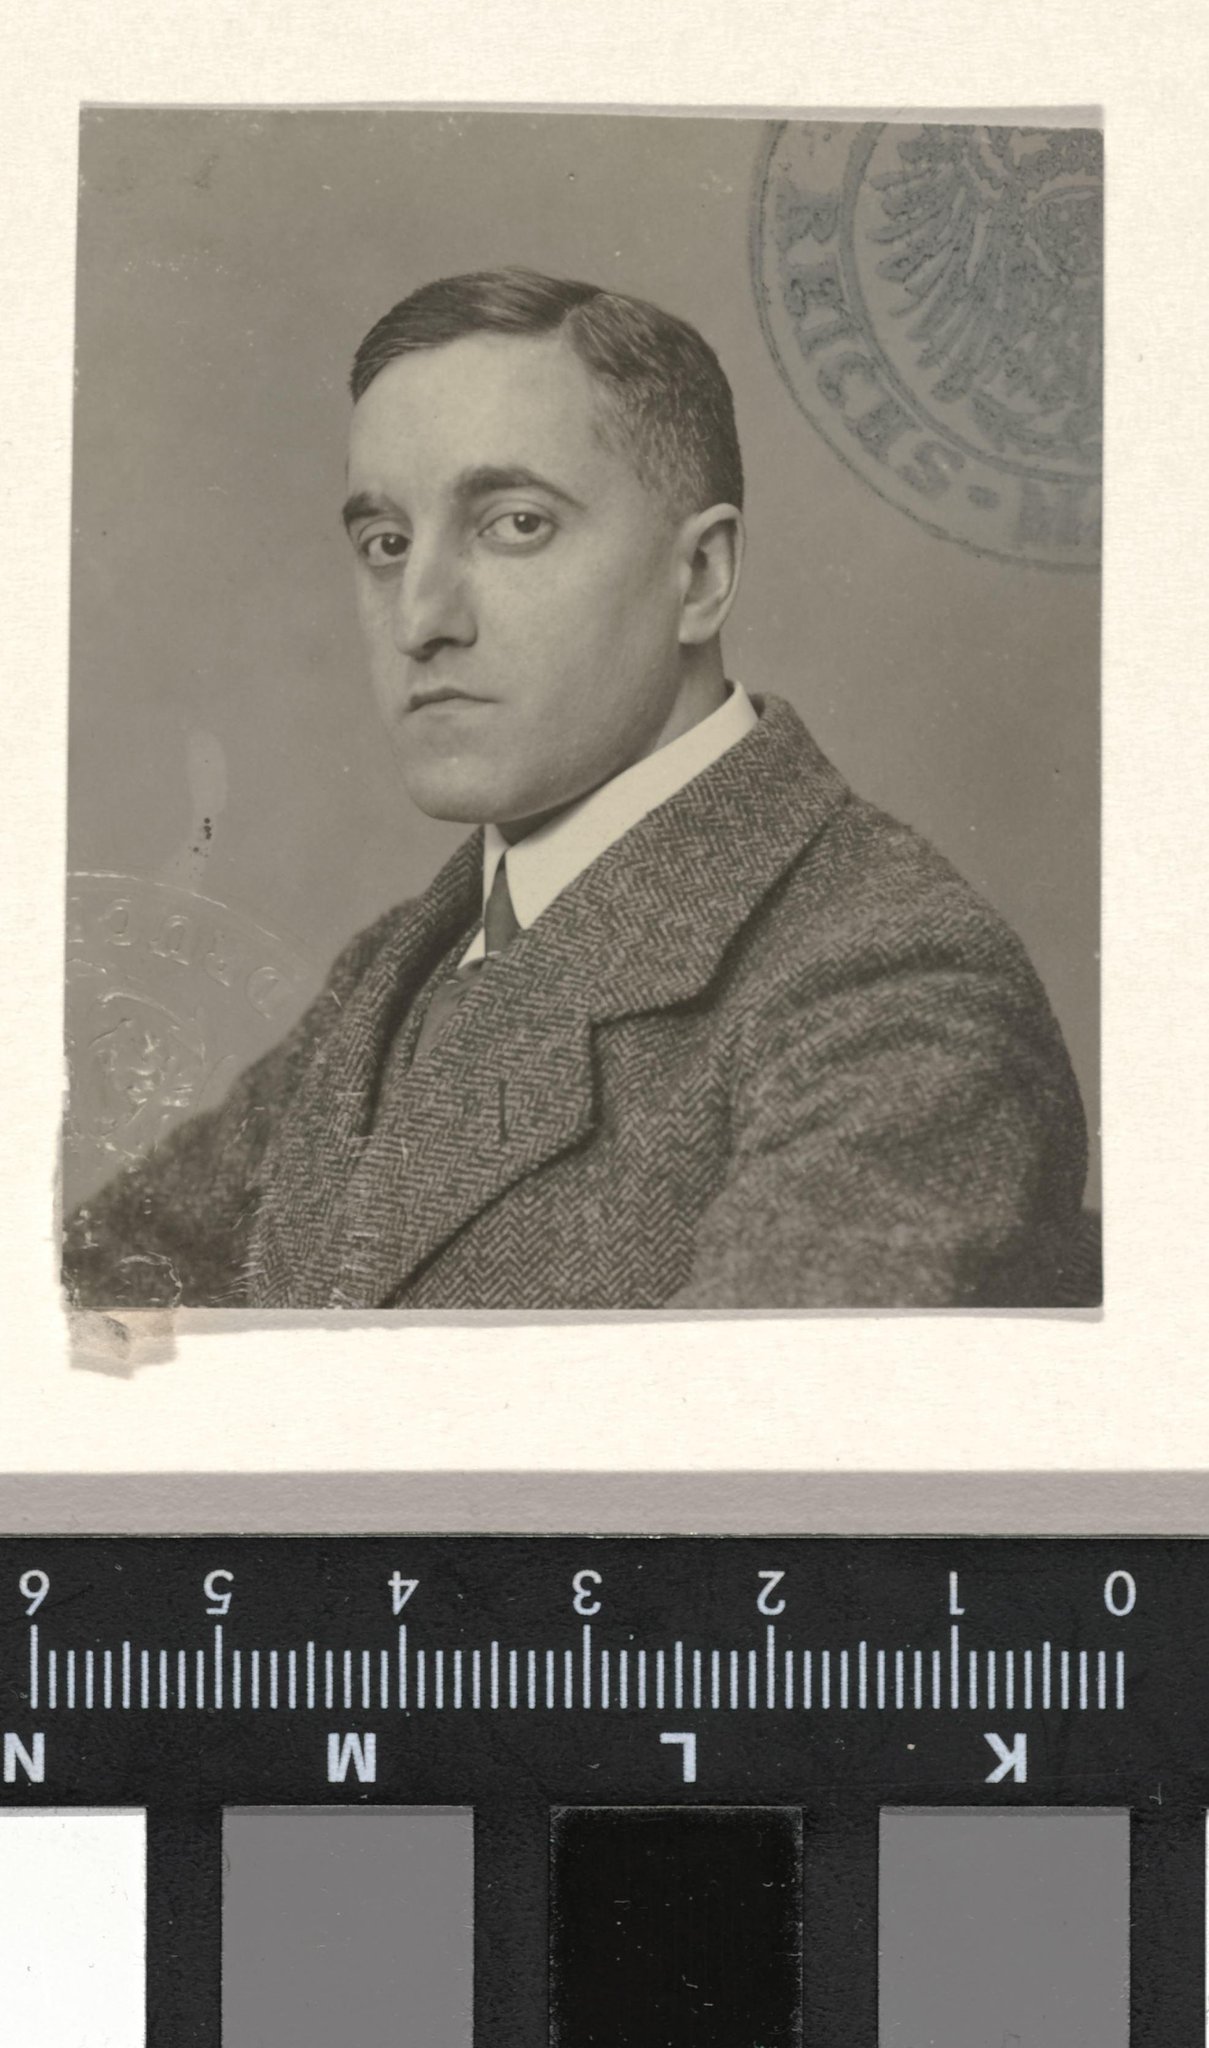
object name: photograph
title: Portret van Eugen Wachenheimer, 1906-1931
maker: Anonymous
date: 1906-1931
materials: photographic support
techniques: gelatin silver print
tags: eugen wachenheimer